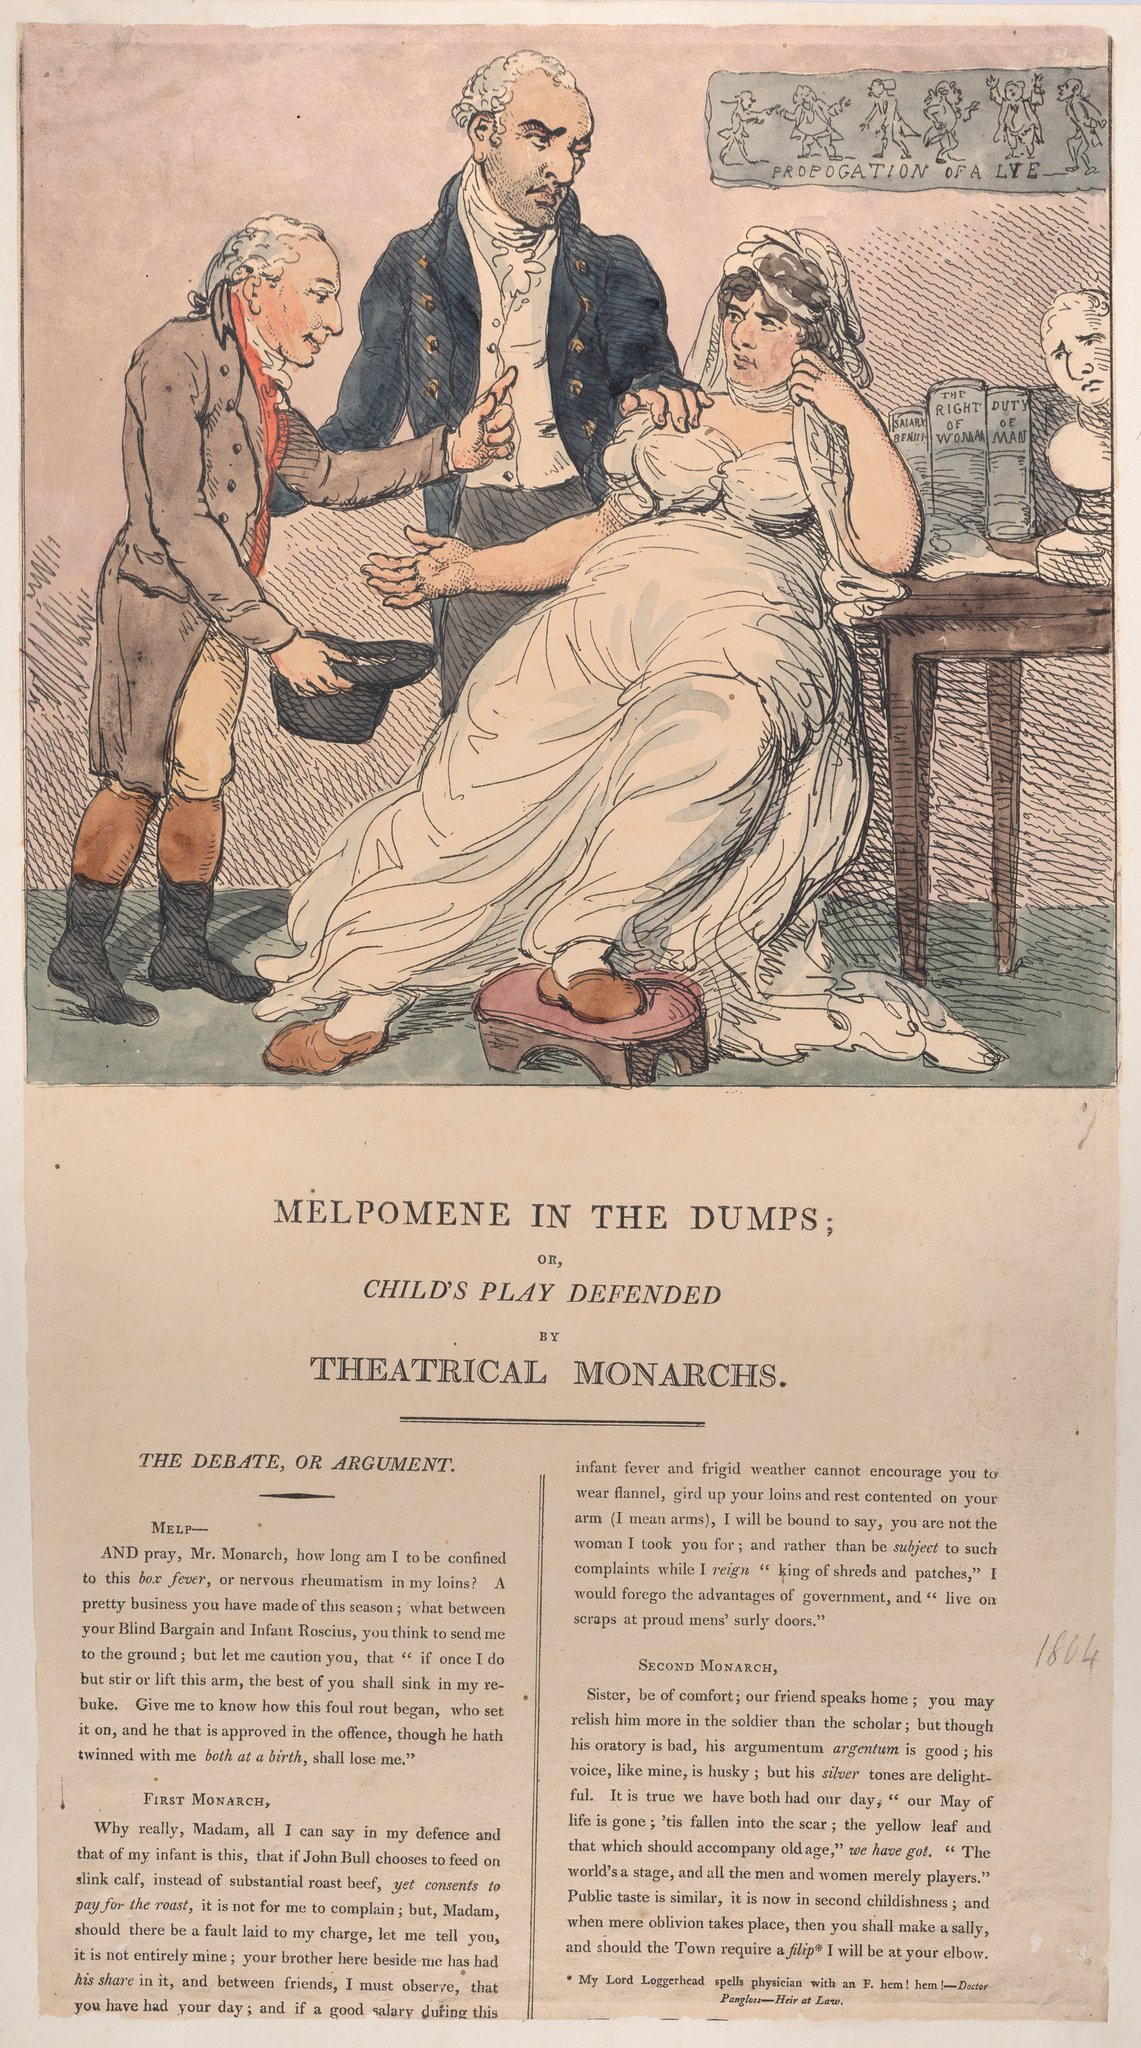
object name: print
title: Melpomene in the Dumps, or Child's Play Defended by Theatrical Monarchs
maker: thomas rowlandson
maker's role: artist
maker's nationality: british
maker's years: 1757-1827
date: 1804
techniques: etching, letterpress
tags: satire,men,women,actresses